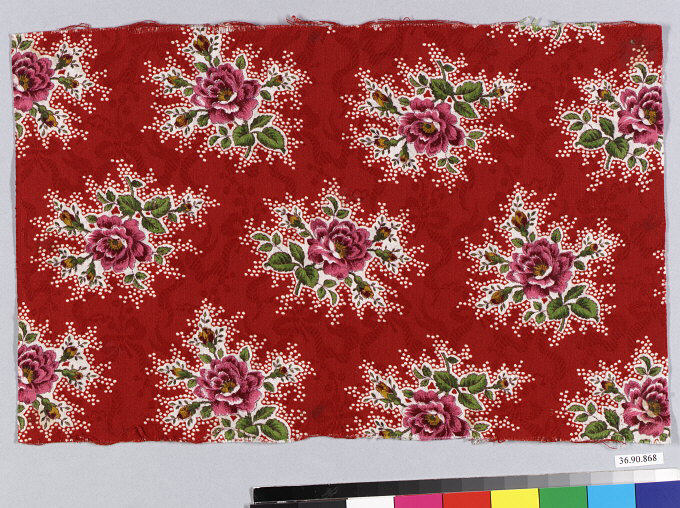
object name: piece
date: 1801-1900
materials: cotton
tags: roses,leaves